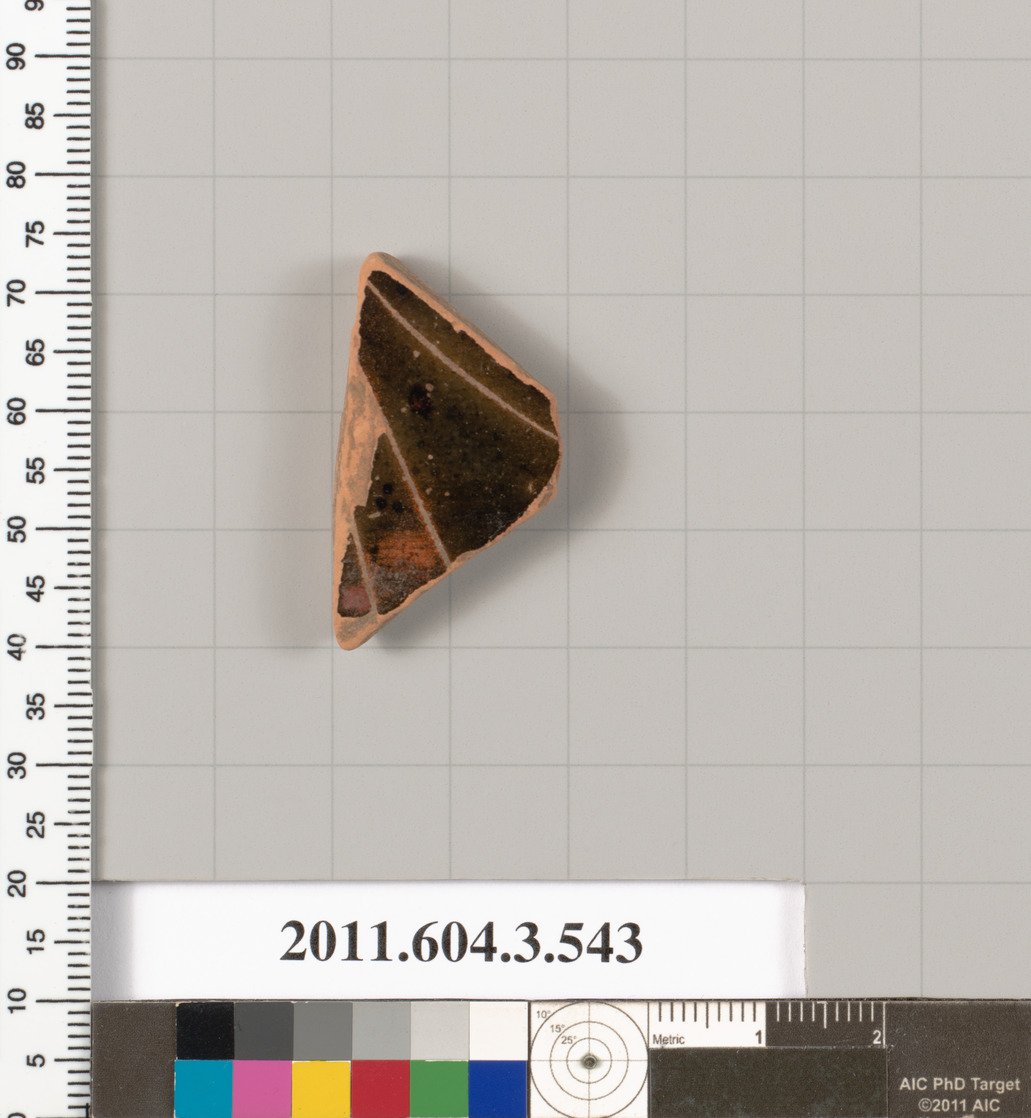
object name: column krater fragment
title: Terracotta fragment of a column-krater (bowl for mixing wine and water)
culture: greek, attic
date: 534-468 BCE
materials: terracotta